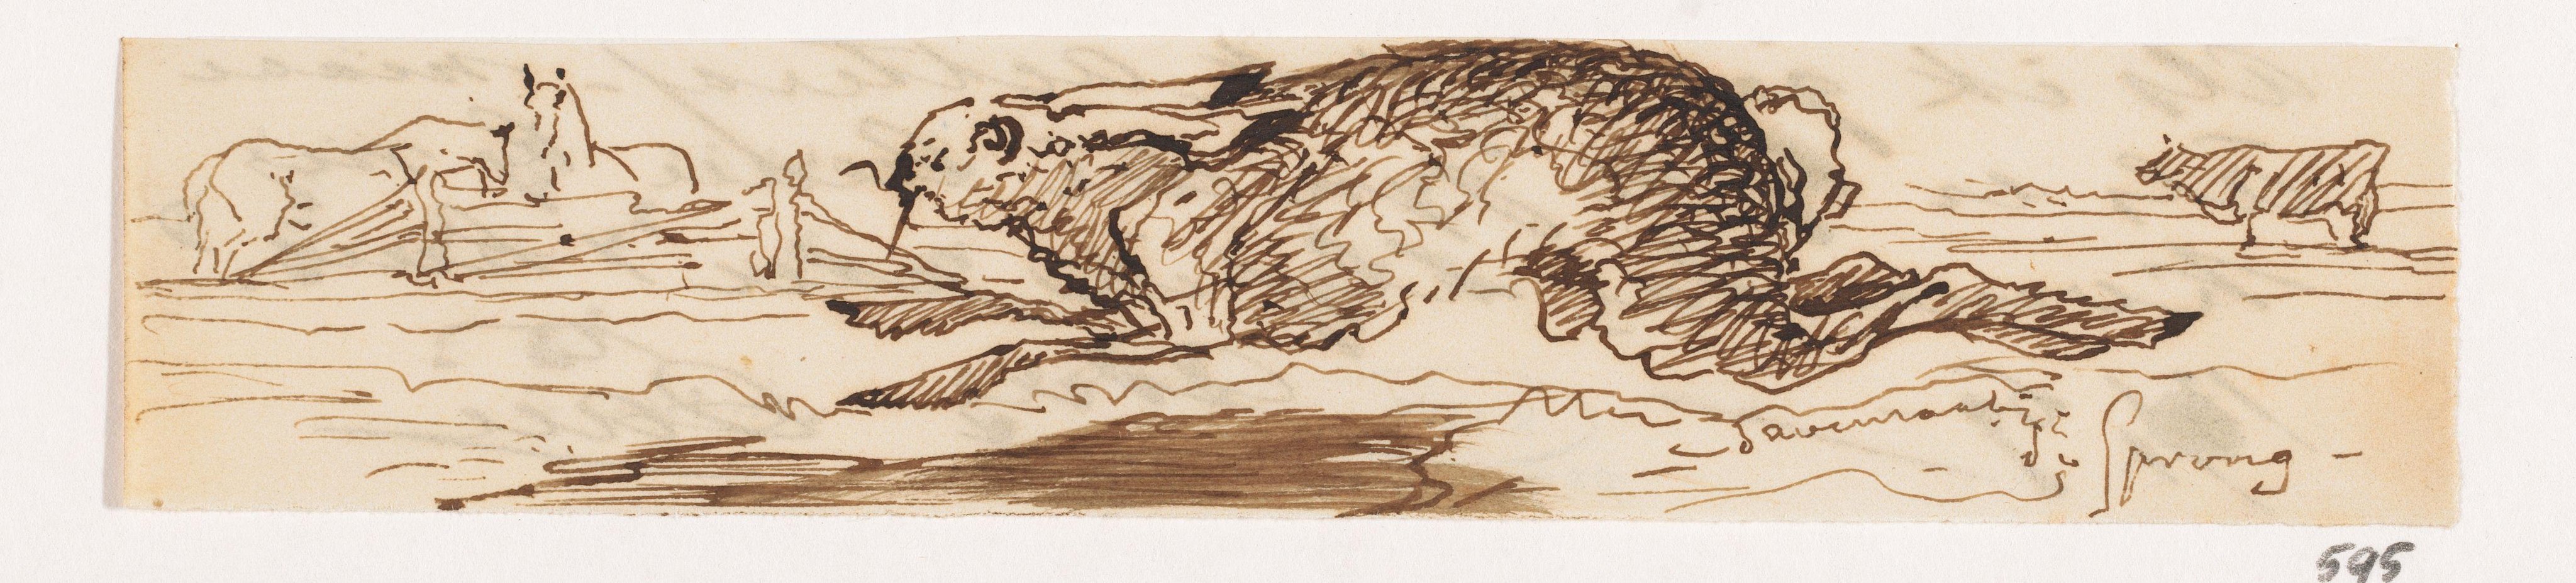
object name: drawing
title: de Sprong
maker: johannes tavenraat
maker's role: draughtsman, painter, print maker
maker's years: 1809-1881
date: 1840-1880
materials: ink, paper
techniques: pen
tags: rodents: hare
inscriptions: annotation: ‘Tavenraat / de Sproong’, collector's mark: Lugt 2228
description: Haas springt over slootje in weiland tussen vee.